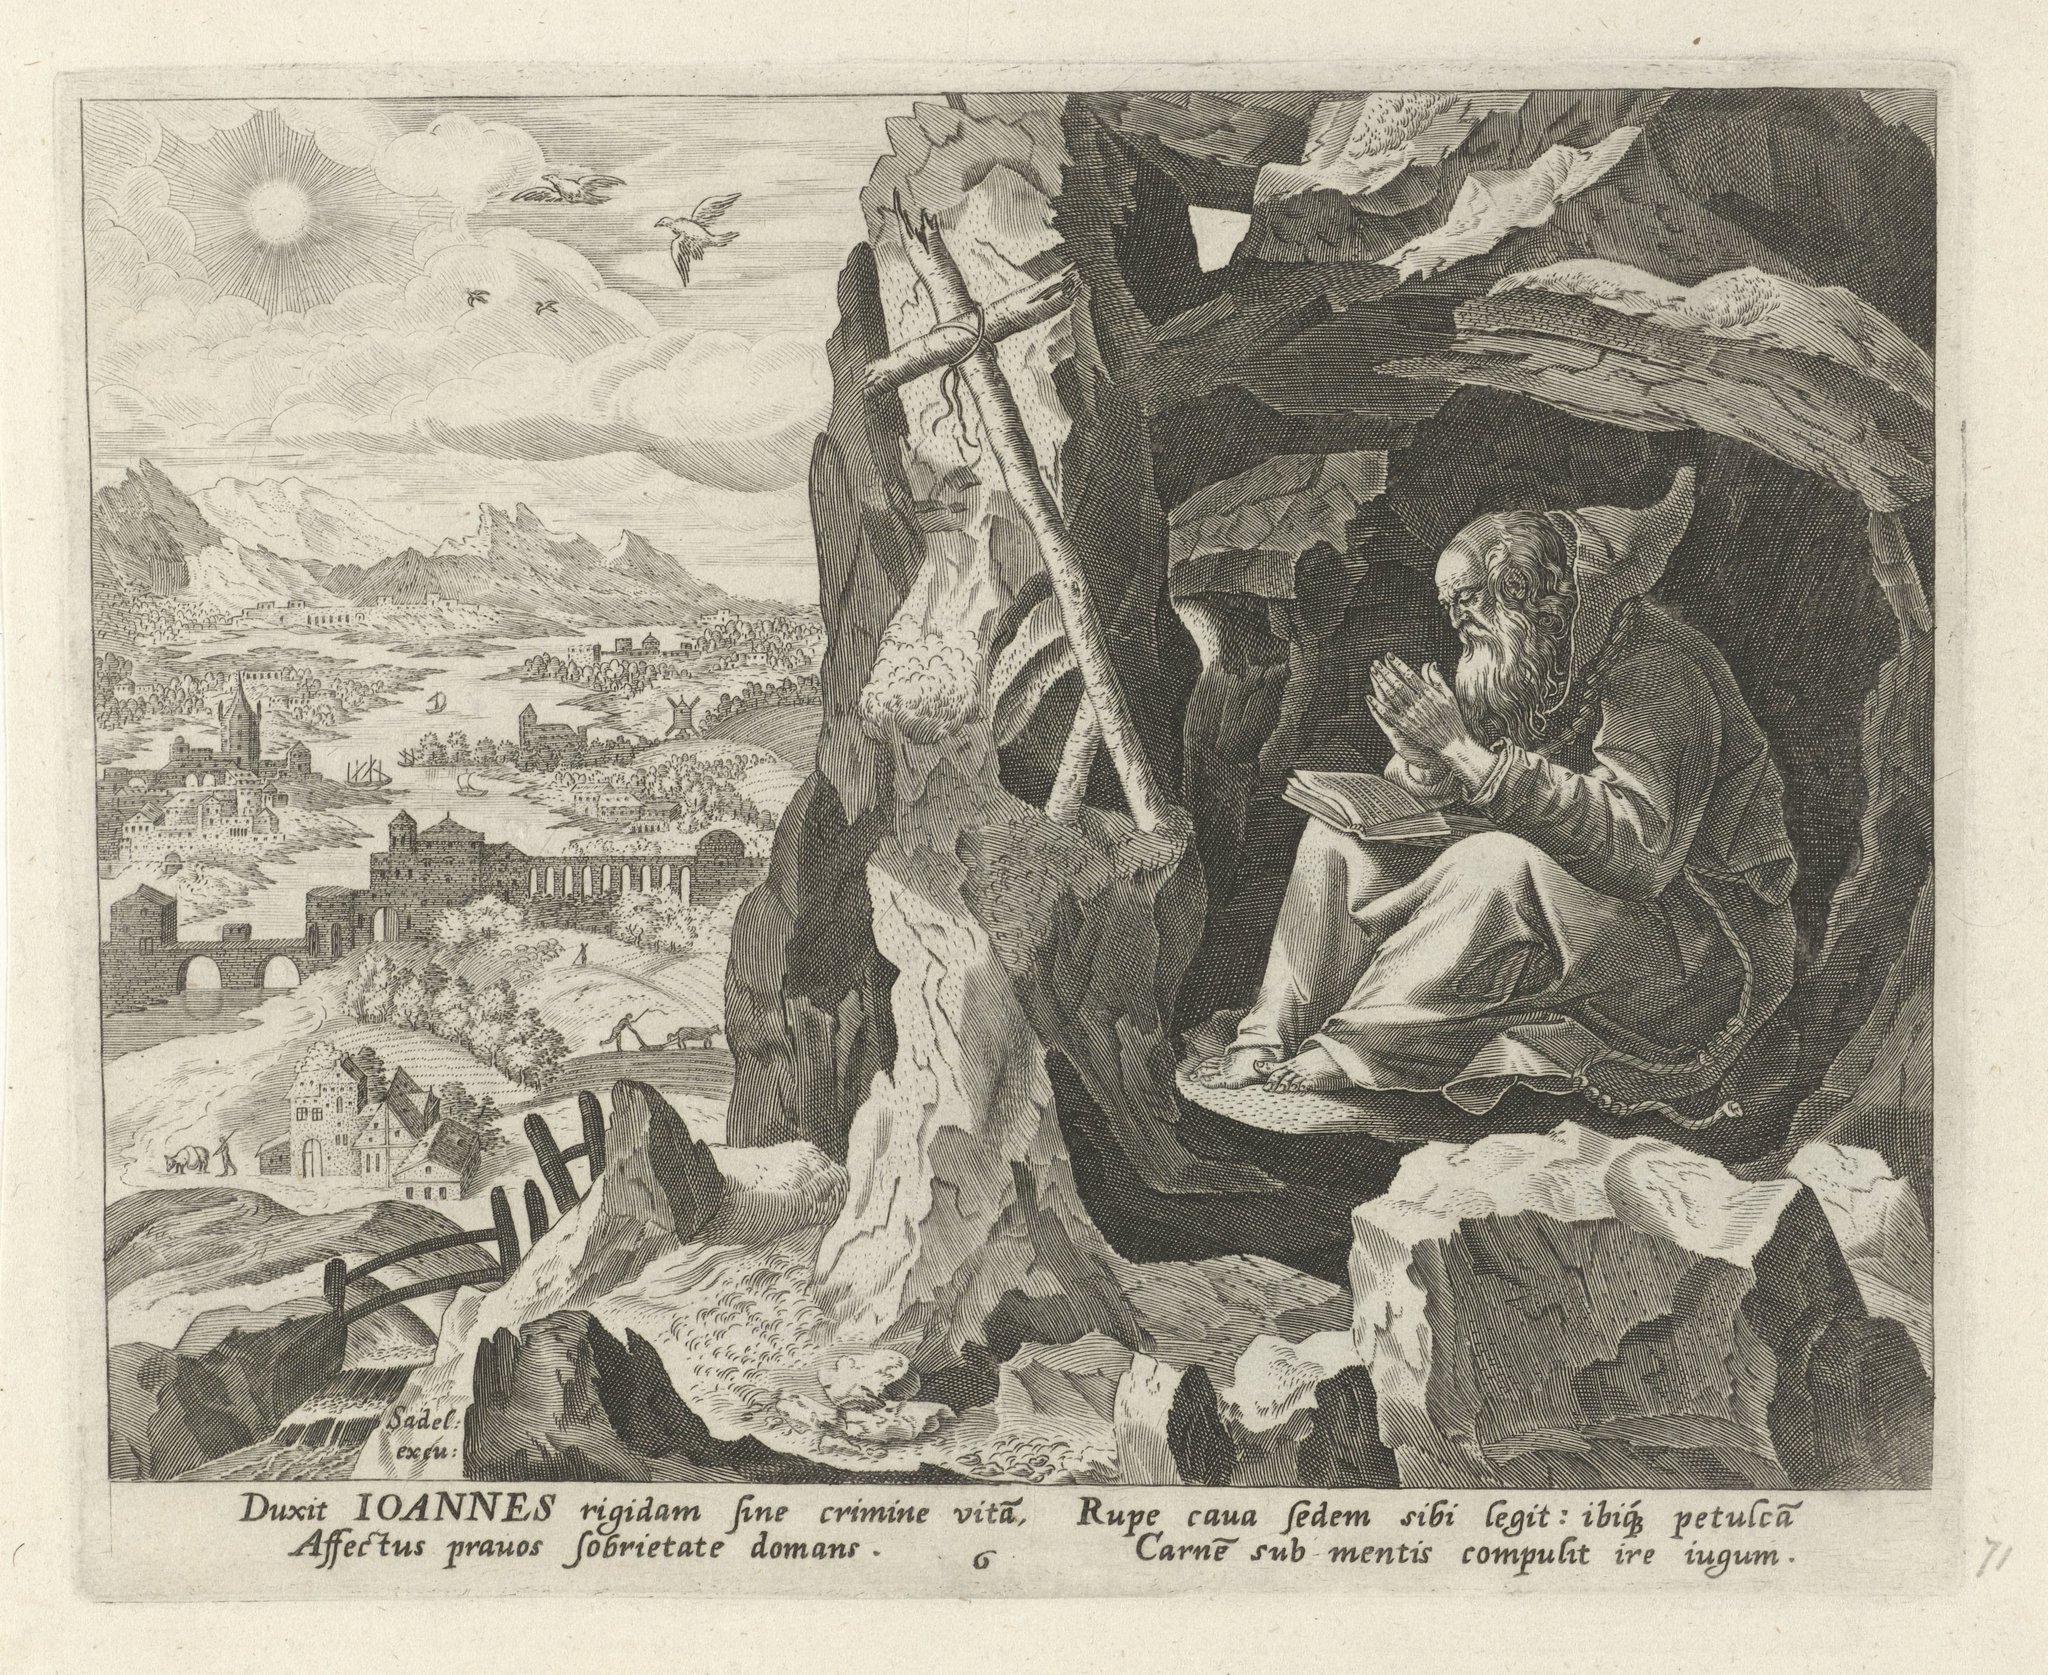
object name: print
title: Johannes Cassianus als kluizenaar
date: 1583-1588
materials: paper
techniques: engraving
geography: antwerp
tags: male saints (with name), anchorite, hermit, cave, grotto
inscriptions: collector's mark: Lugt 2228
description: De H. Johannes Cassianus in een grot in de woestijn. Hij zit voor een crucifix en leest een bijbel terwijl hij bidt. Een landschap op de achtergrond.